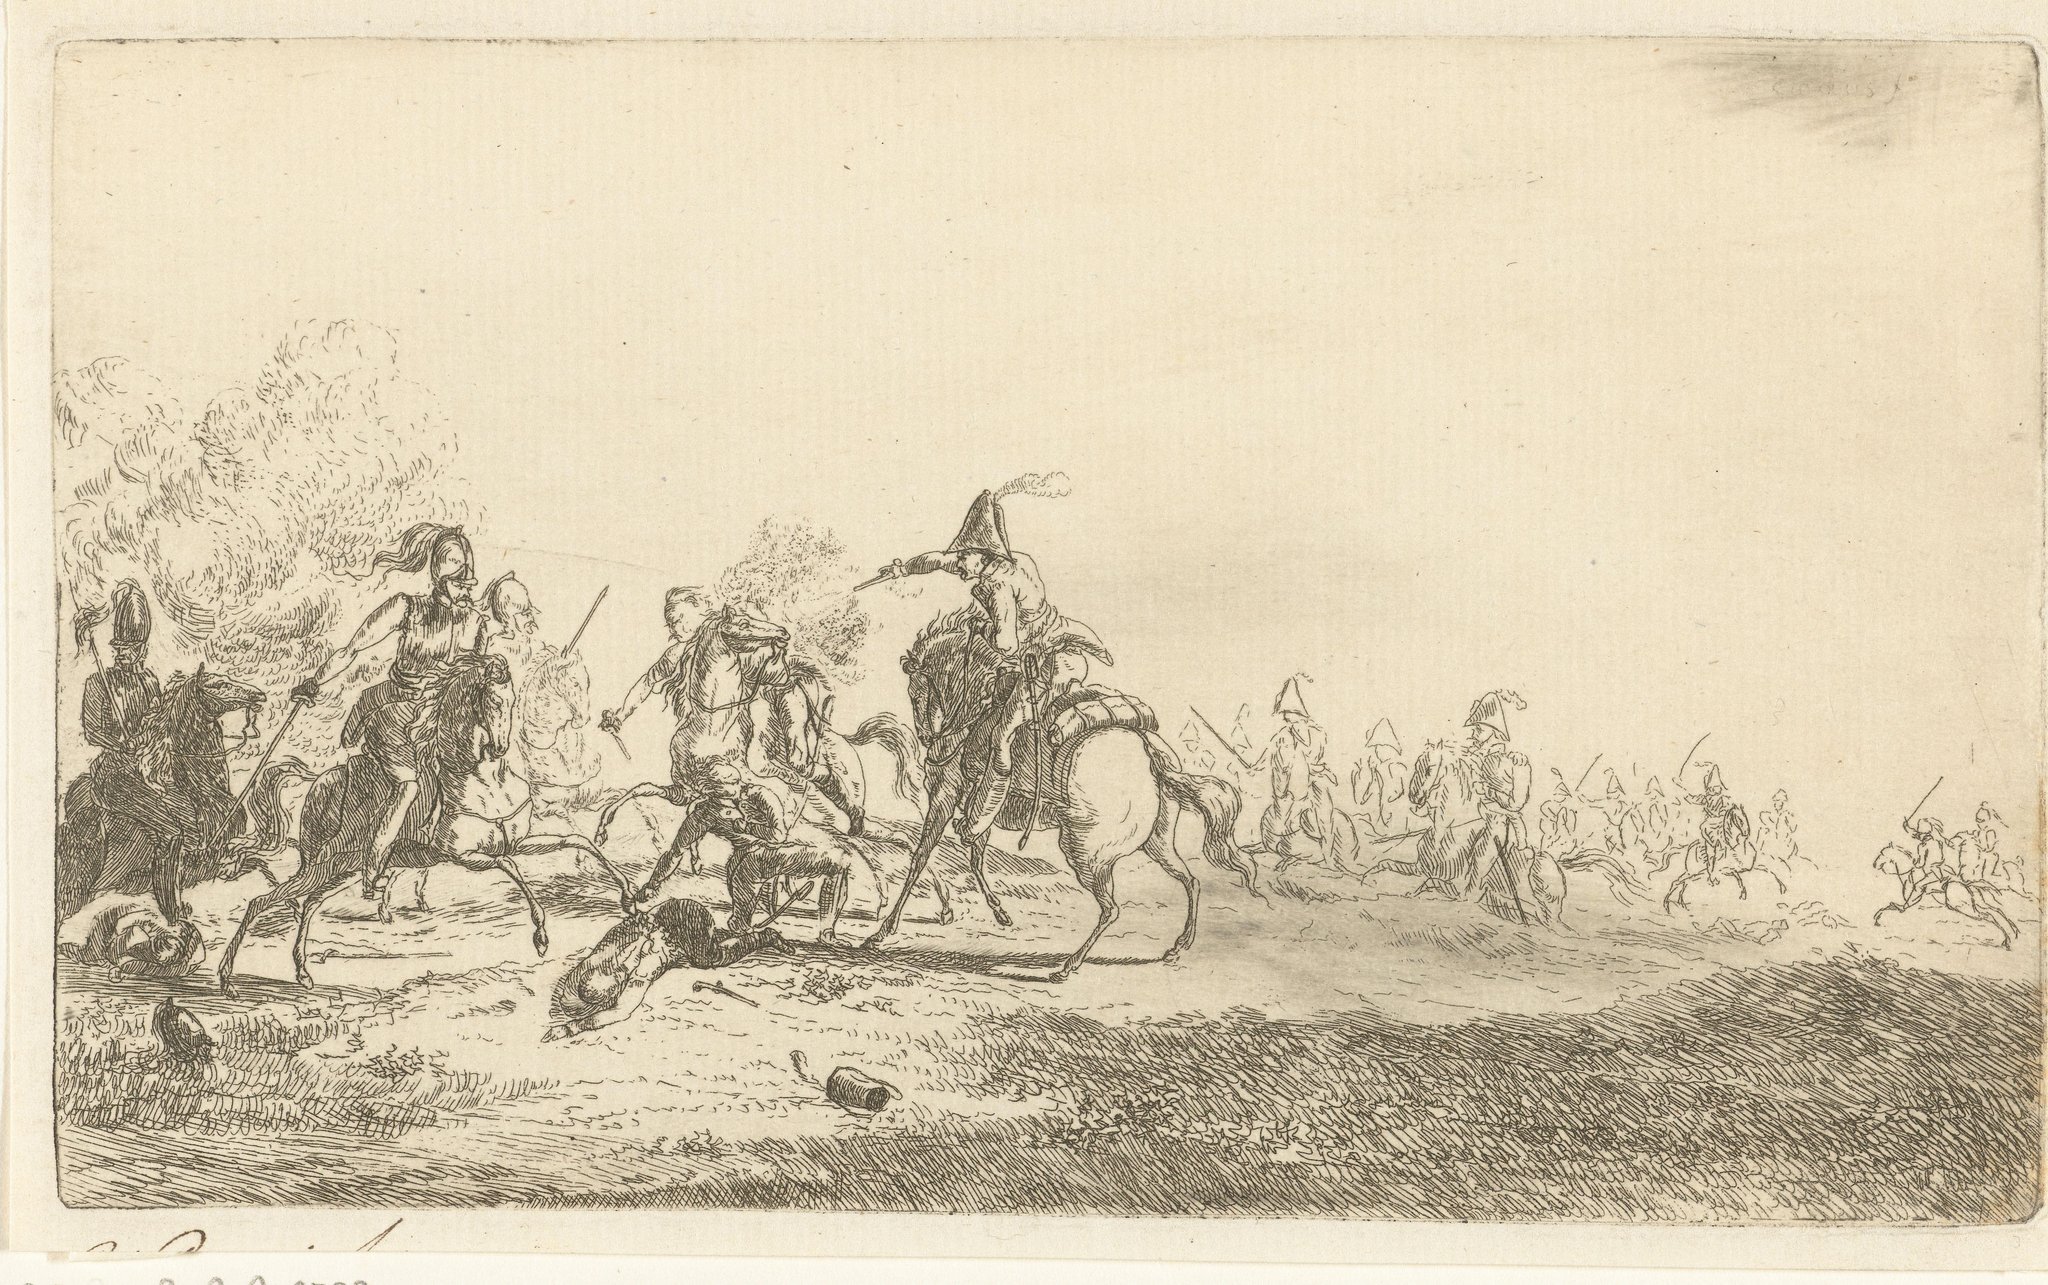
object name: print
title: Slagveldtafereel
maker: gerardus emaus de micault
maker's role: draughtsman, print maker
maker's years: 1798-1863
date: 1813-1863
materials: paper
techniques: etching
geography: netherlands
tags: battle (+ cavalry, horsemen)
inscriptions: collector's mark: Lugt 2228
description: Cavalerie gevecht. Een soldaat met steek op het hoofd, schiet vanaf zijn paard op een tegenstander, terwijl rondom cavaleristen komen aanrijden. Op de grond ligt een gesneuvelde man.